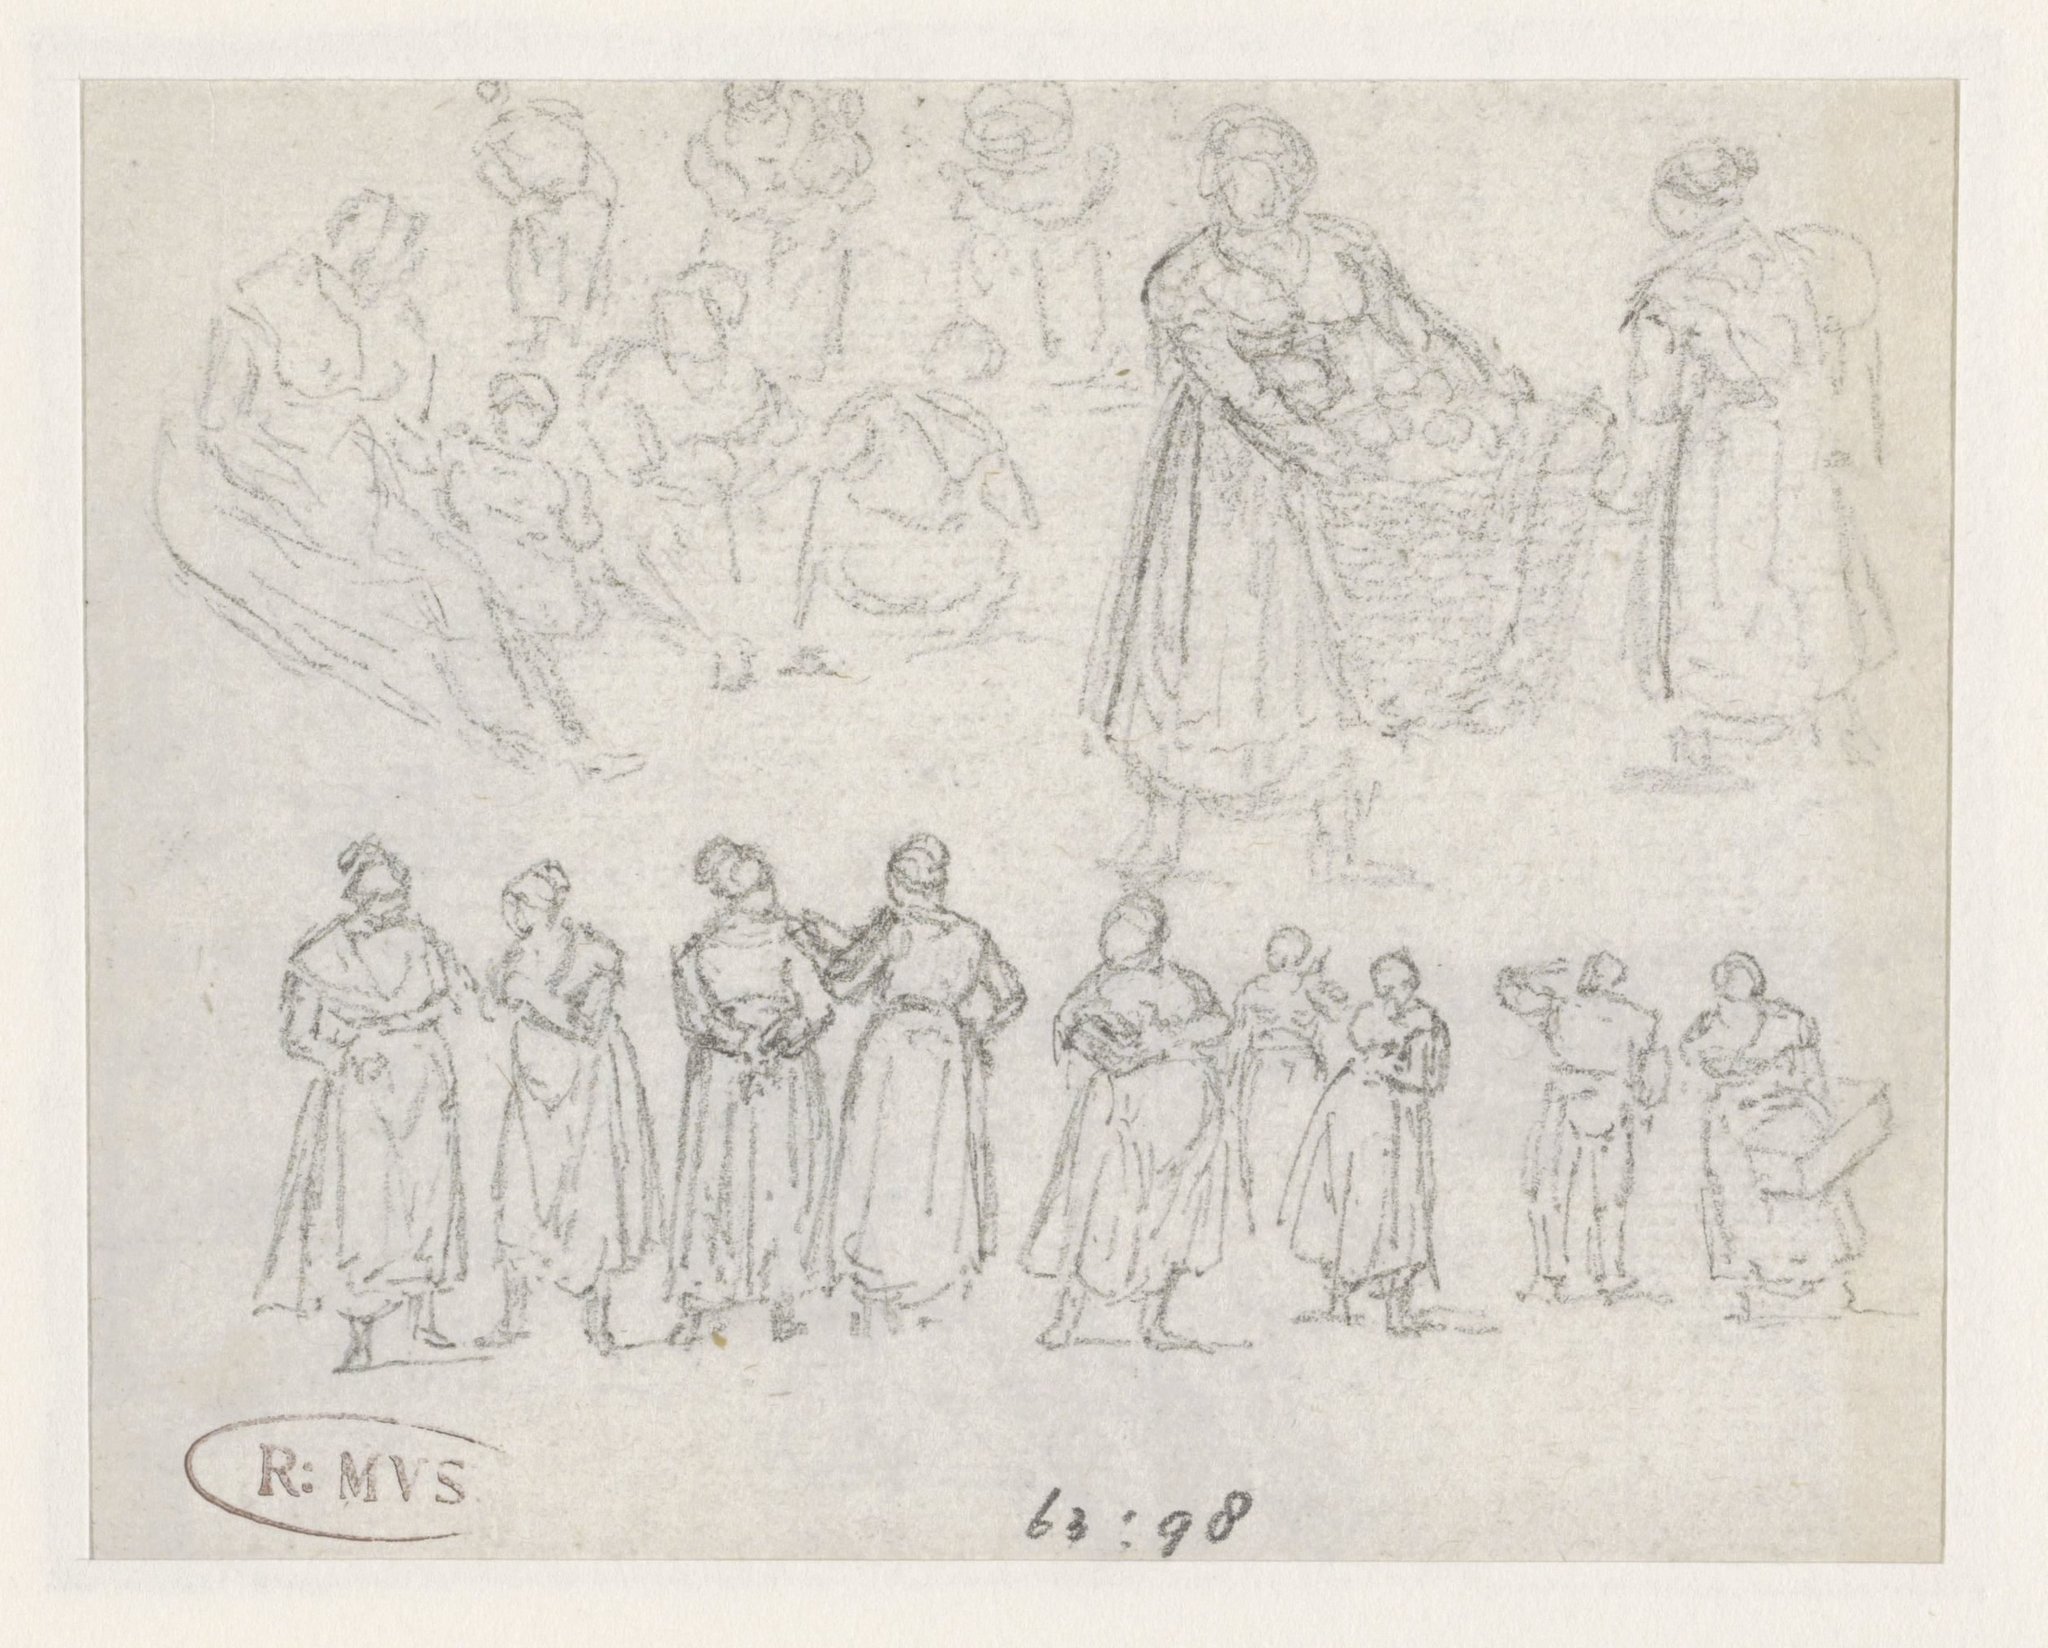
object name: drawing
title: Volksvrouwen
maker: georges michel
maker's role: draughtsman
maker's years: 1763-1843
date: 1773-1843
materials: paper, pencil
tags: standing figure - aa - female human figure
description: Een van 120 tekeningen, afkomstig uit een 19e eeuws album met tekeningen van Georges Michel.